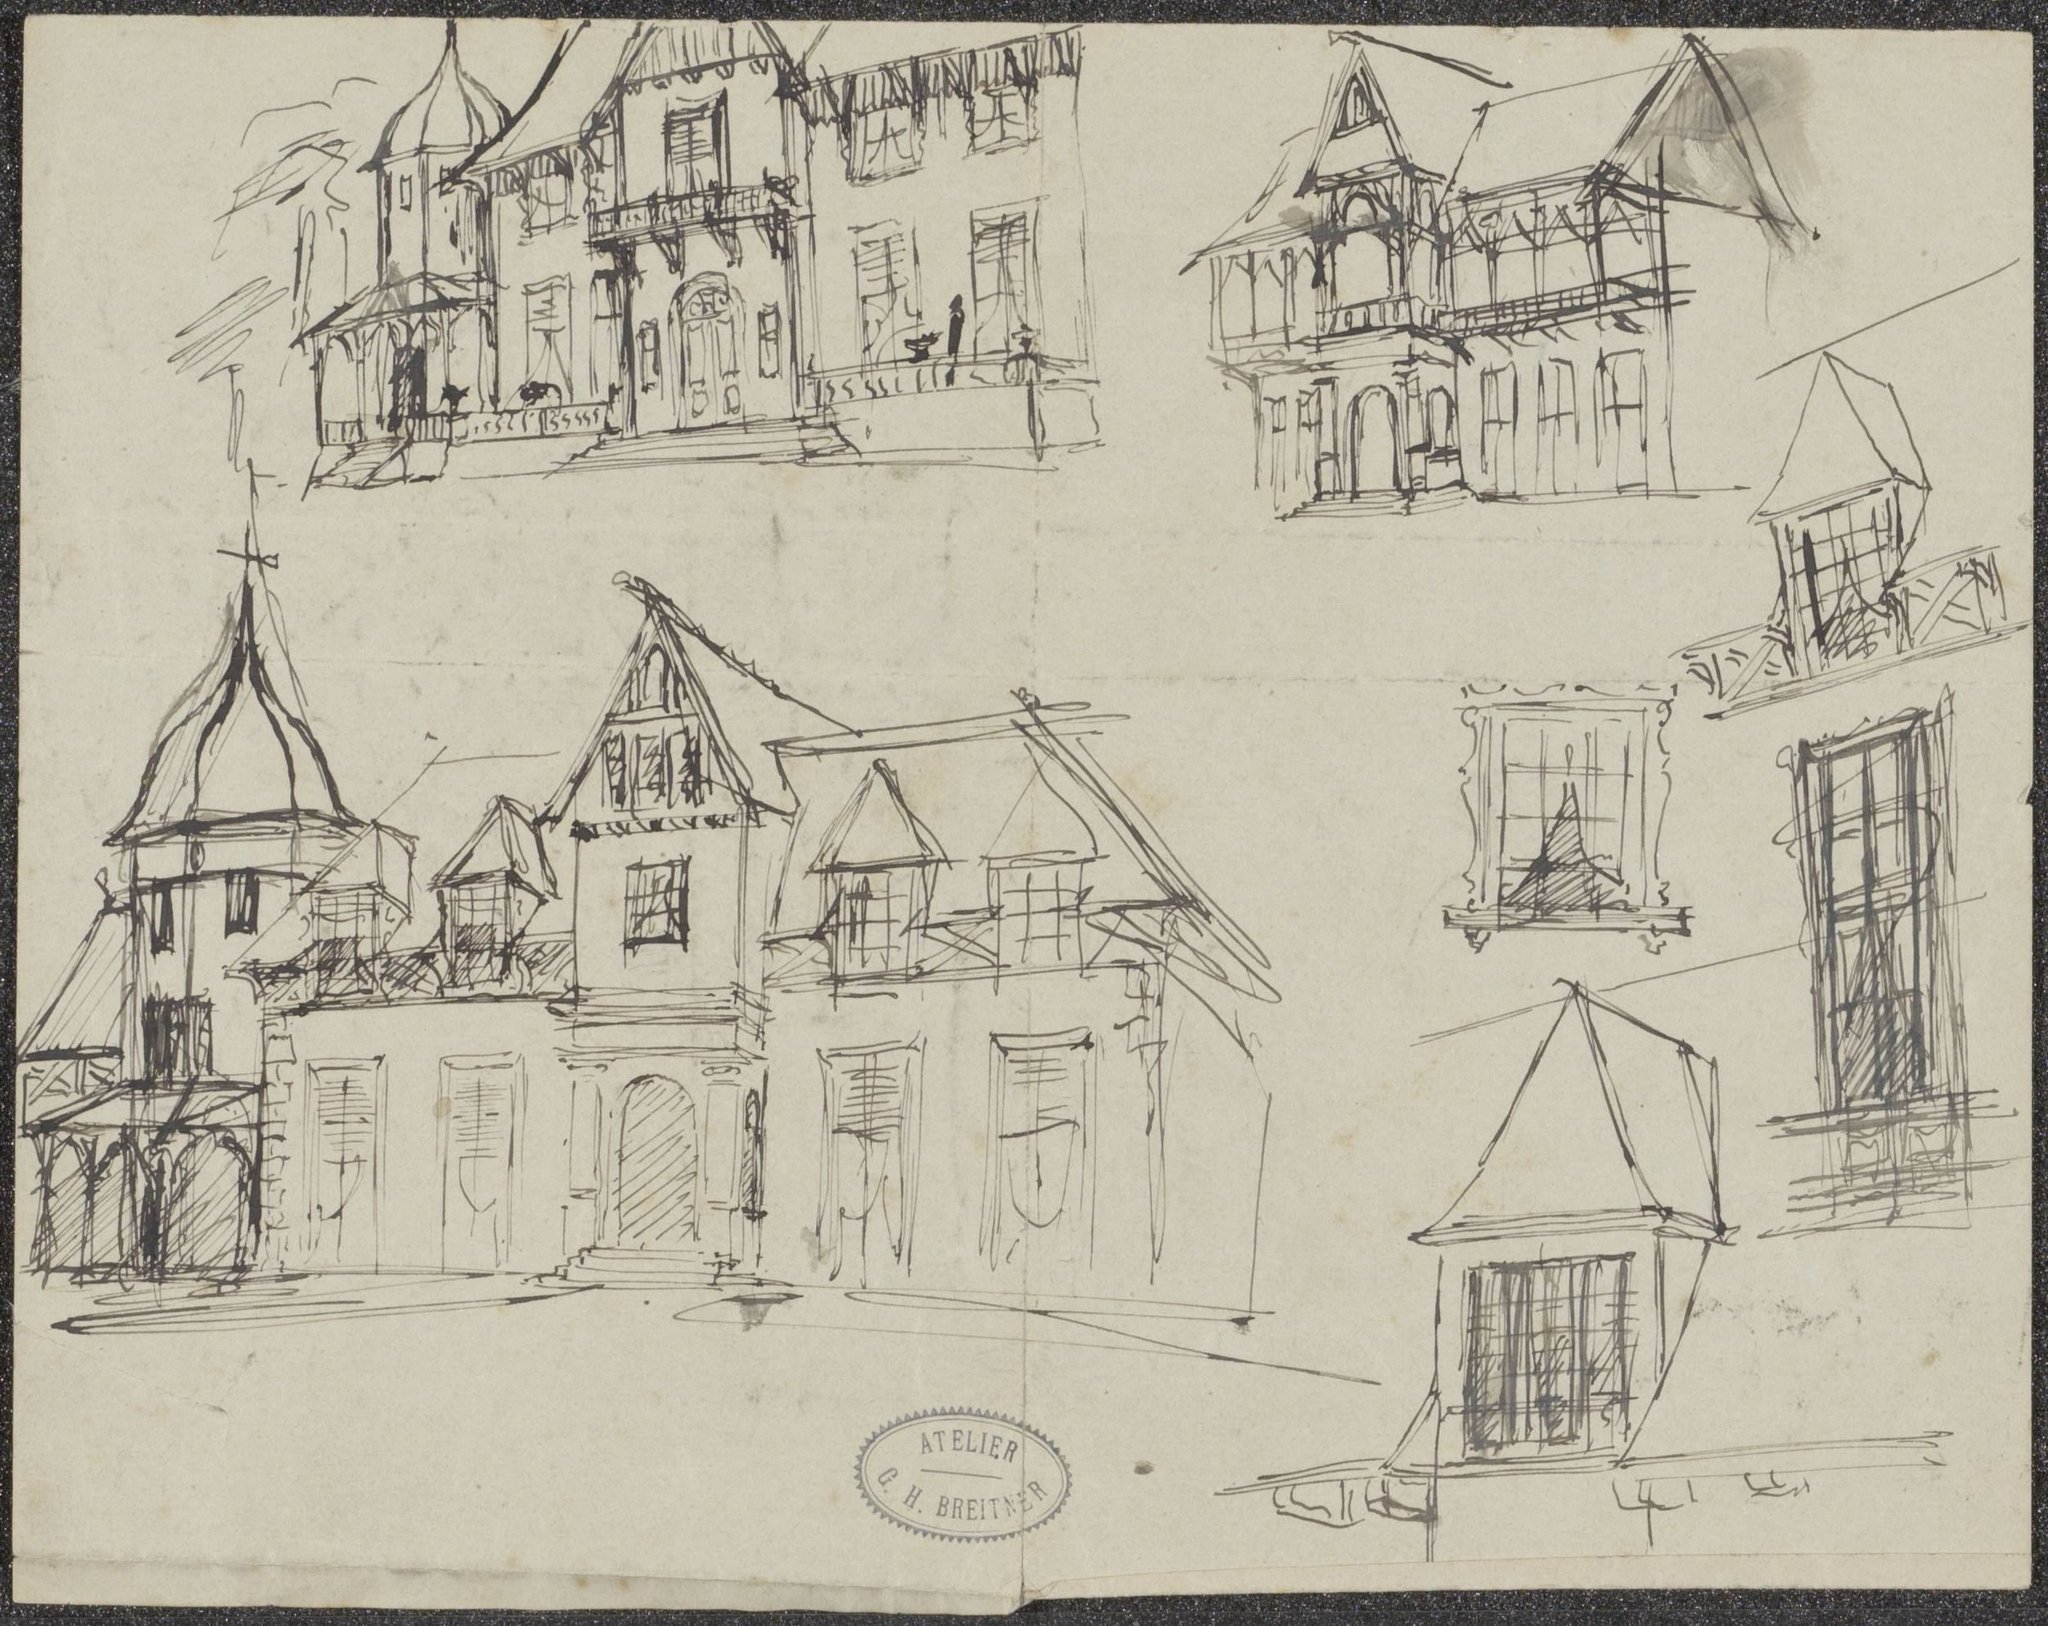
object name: drawing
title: Studieblad met villa's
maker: george hendrik breitner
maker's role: draughtsman, painter, print maker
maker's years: 1857-1923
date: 1873-1882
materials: ink, paper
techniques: pen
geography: south holland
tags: villa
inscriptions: collector's mark: Lugt 2228, workshop stamp: Lugt 291d